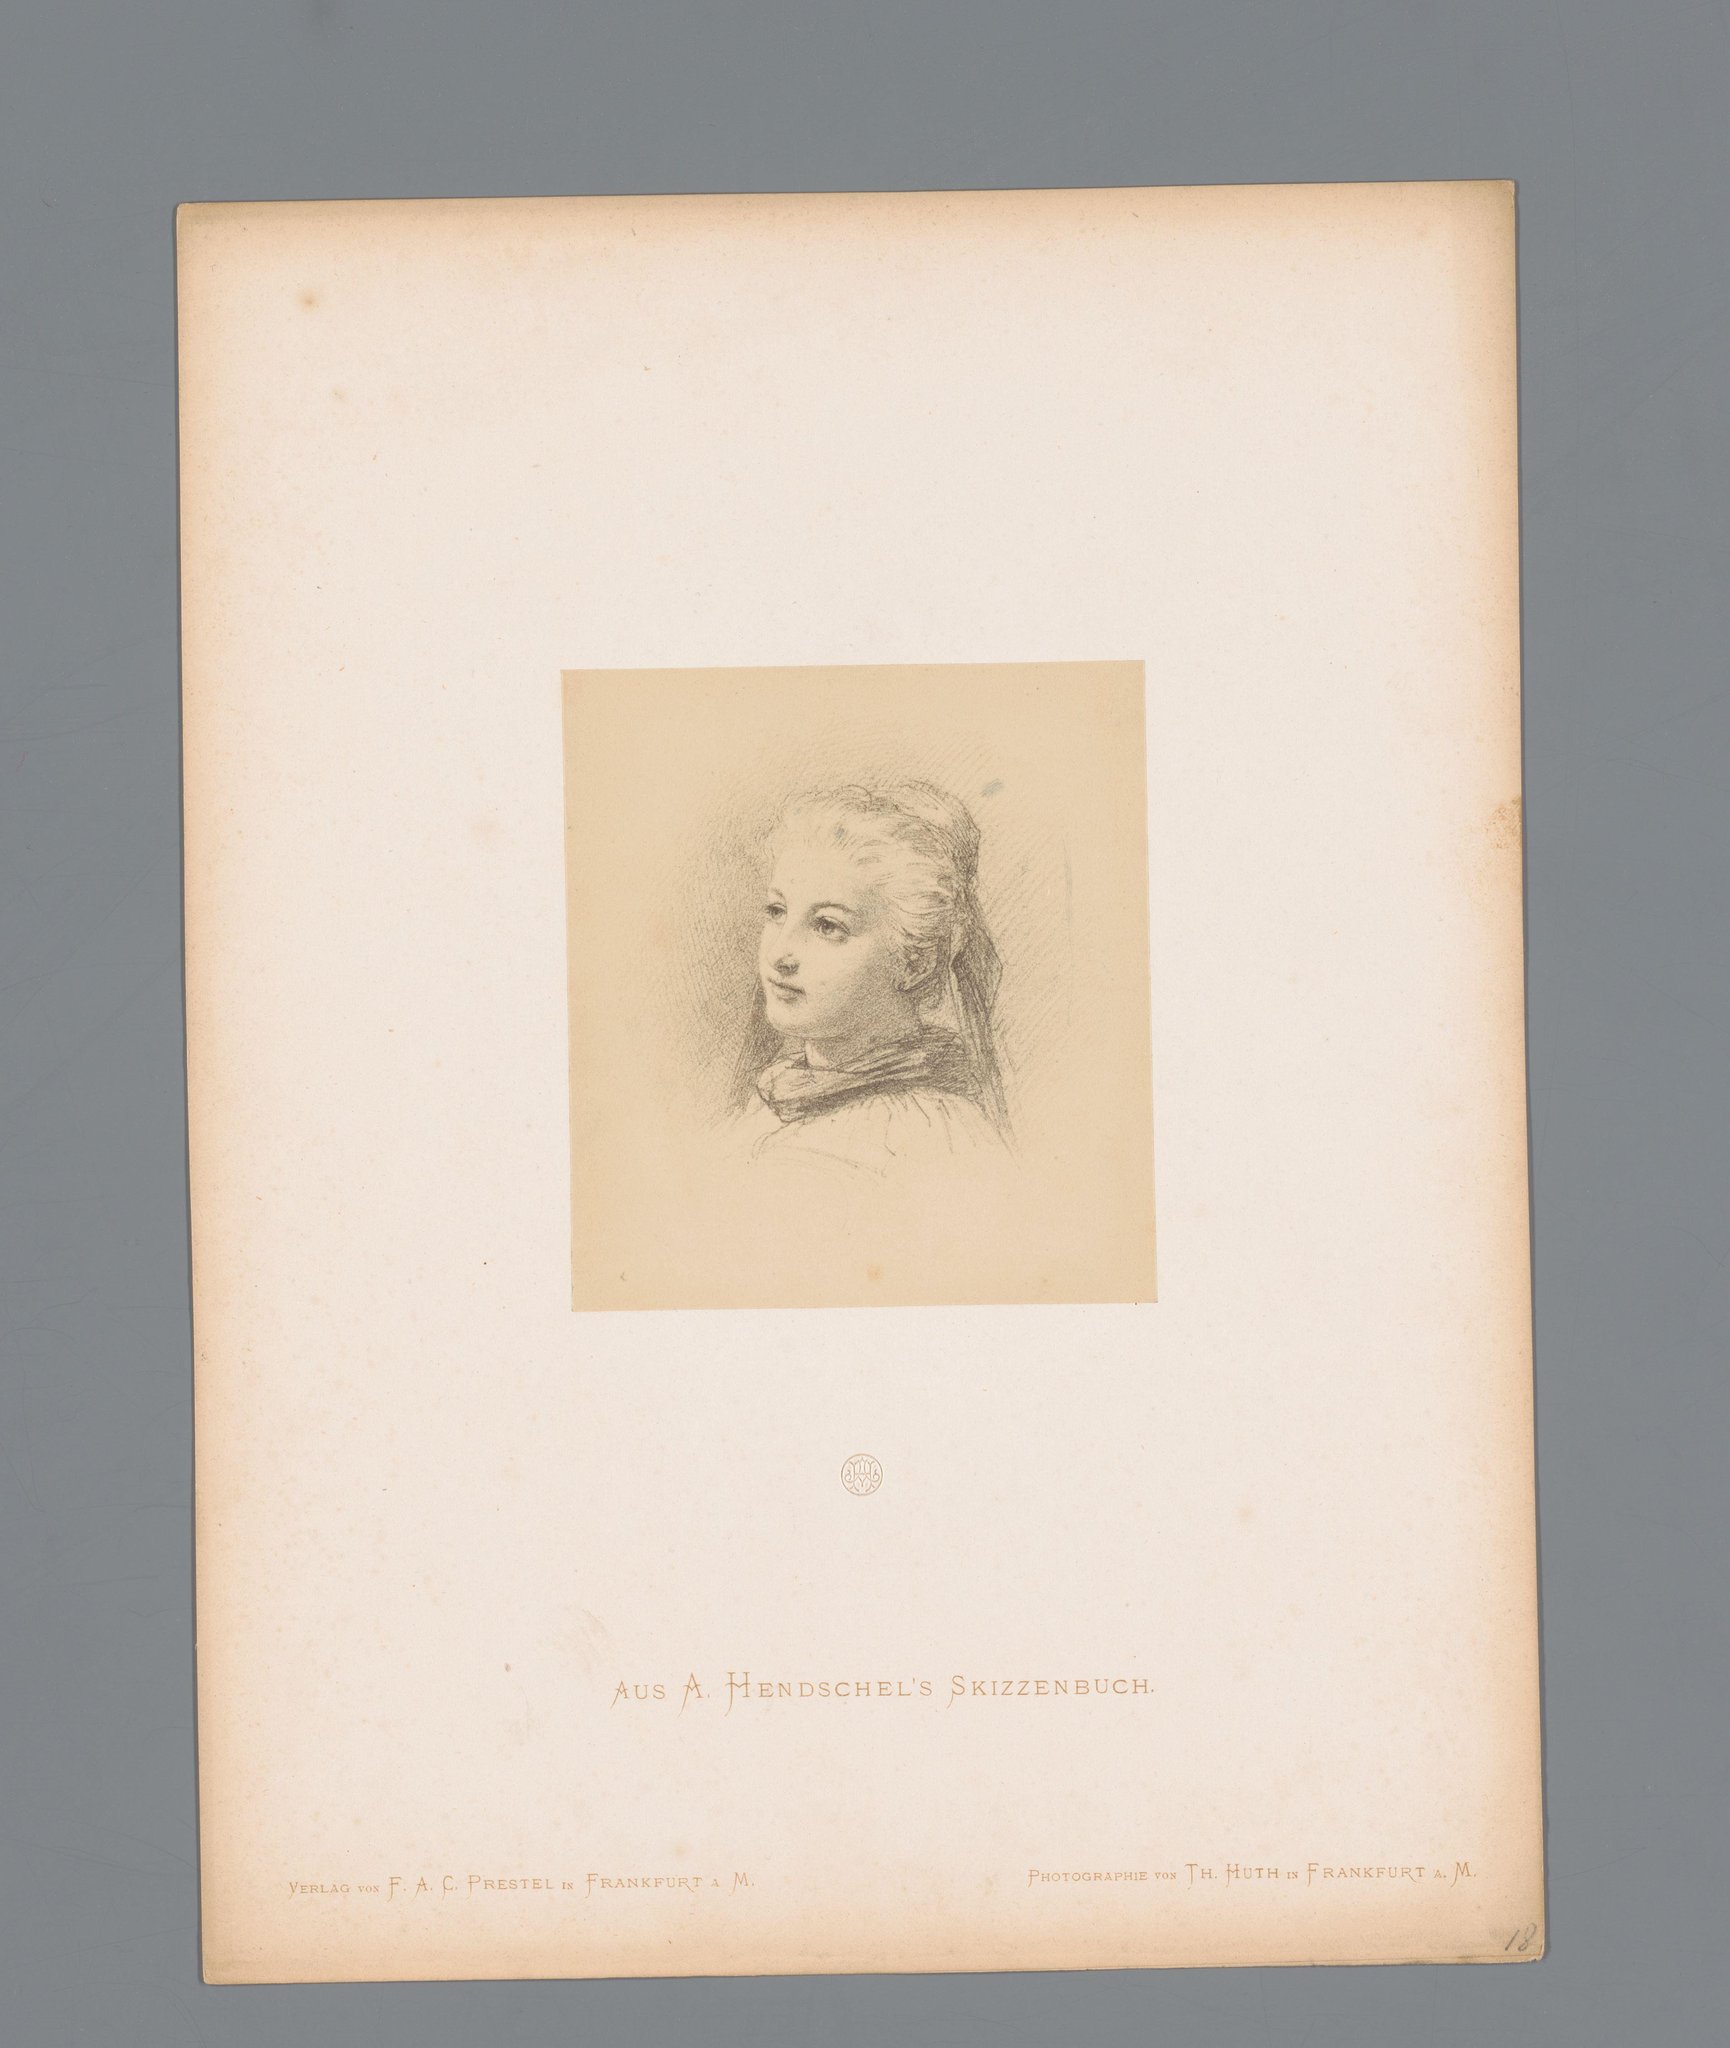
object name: reproduction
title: Aus A. Hendschel's Skizzenbuch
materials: photographic support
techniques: albumen print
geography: frankfurt am main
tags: historical persons not known by name - bb - woman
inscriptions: monogram: ‘AH’, number: ‘18’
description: Deze foto maakt deel uit van een omslag met 50 foto's op 48 bladen, een lijst van afbeeldingen en een titelblad.